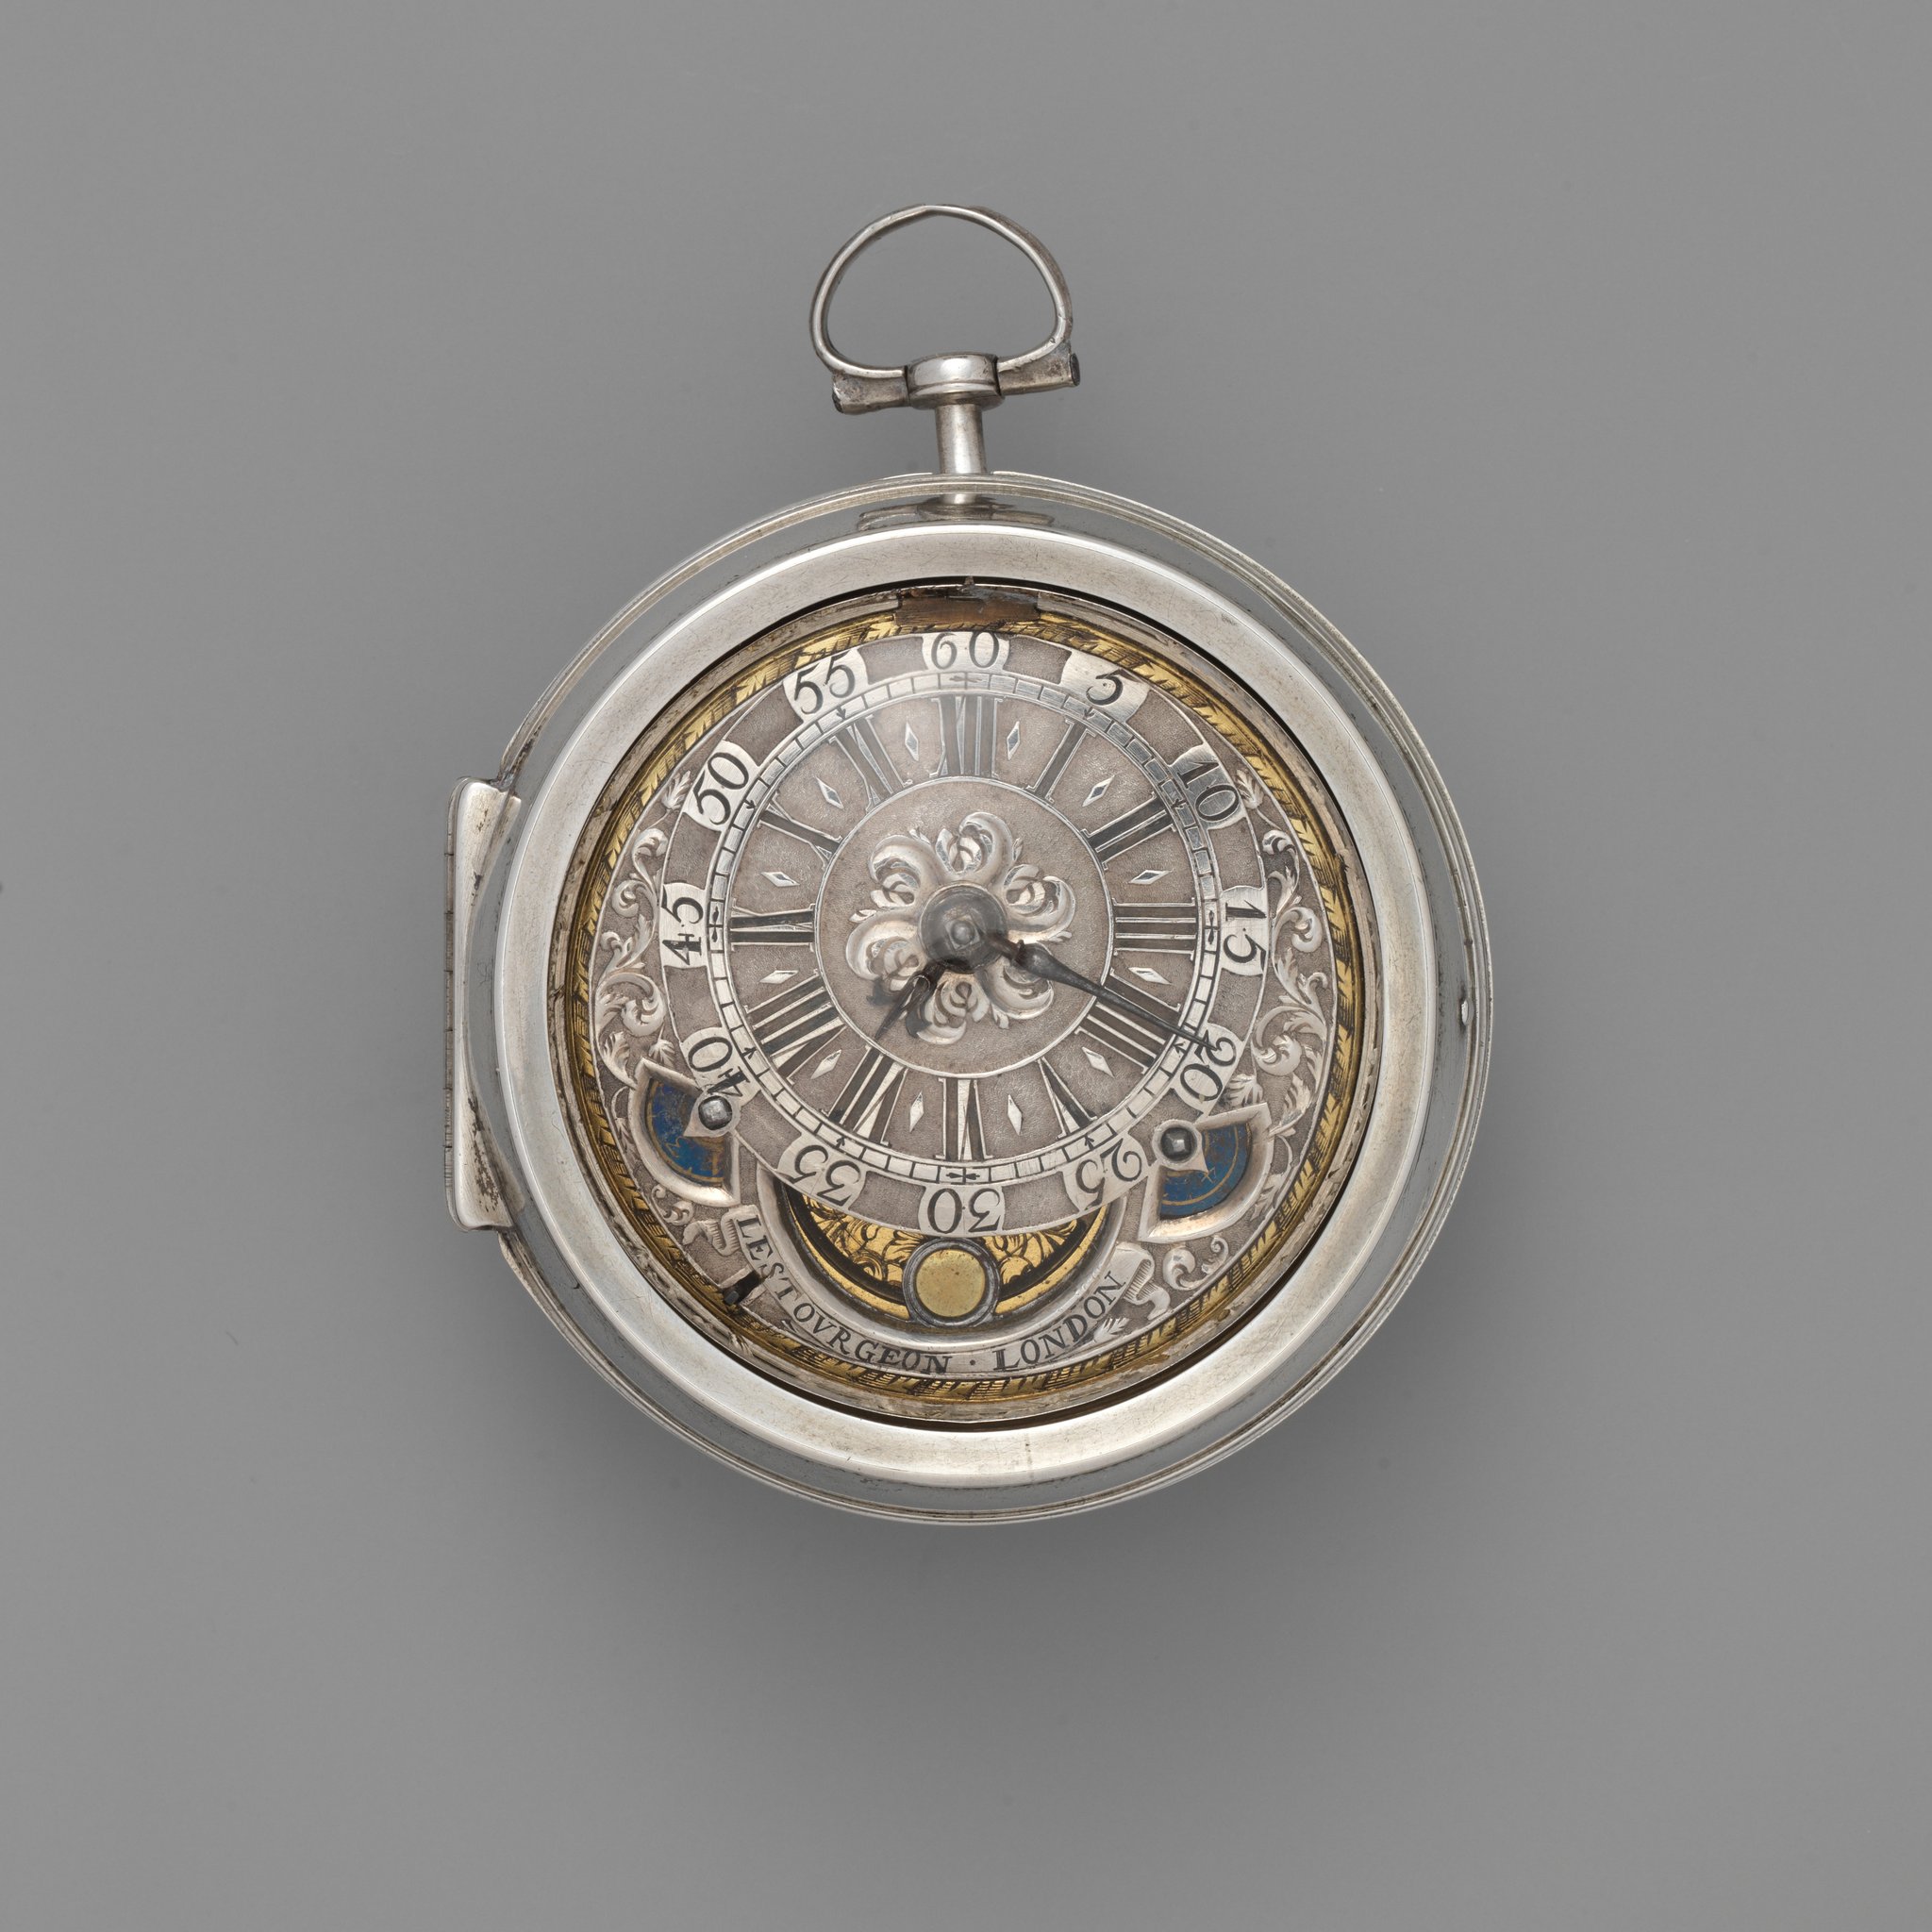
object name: watch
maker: david lestourgeon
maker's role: maker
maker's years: 1631-1731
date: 1702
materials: silver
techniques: enamel